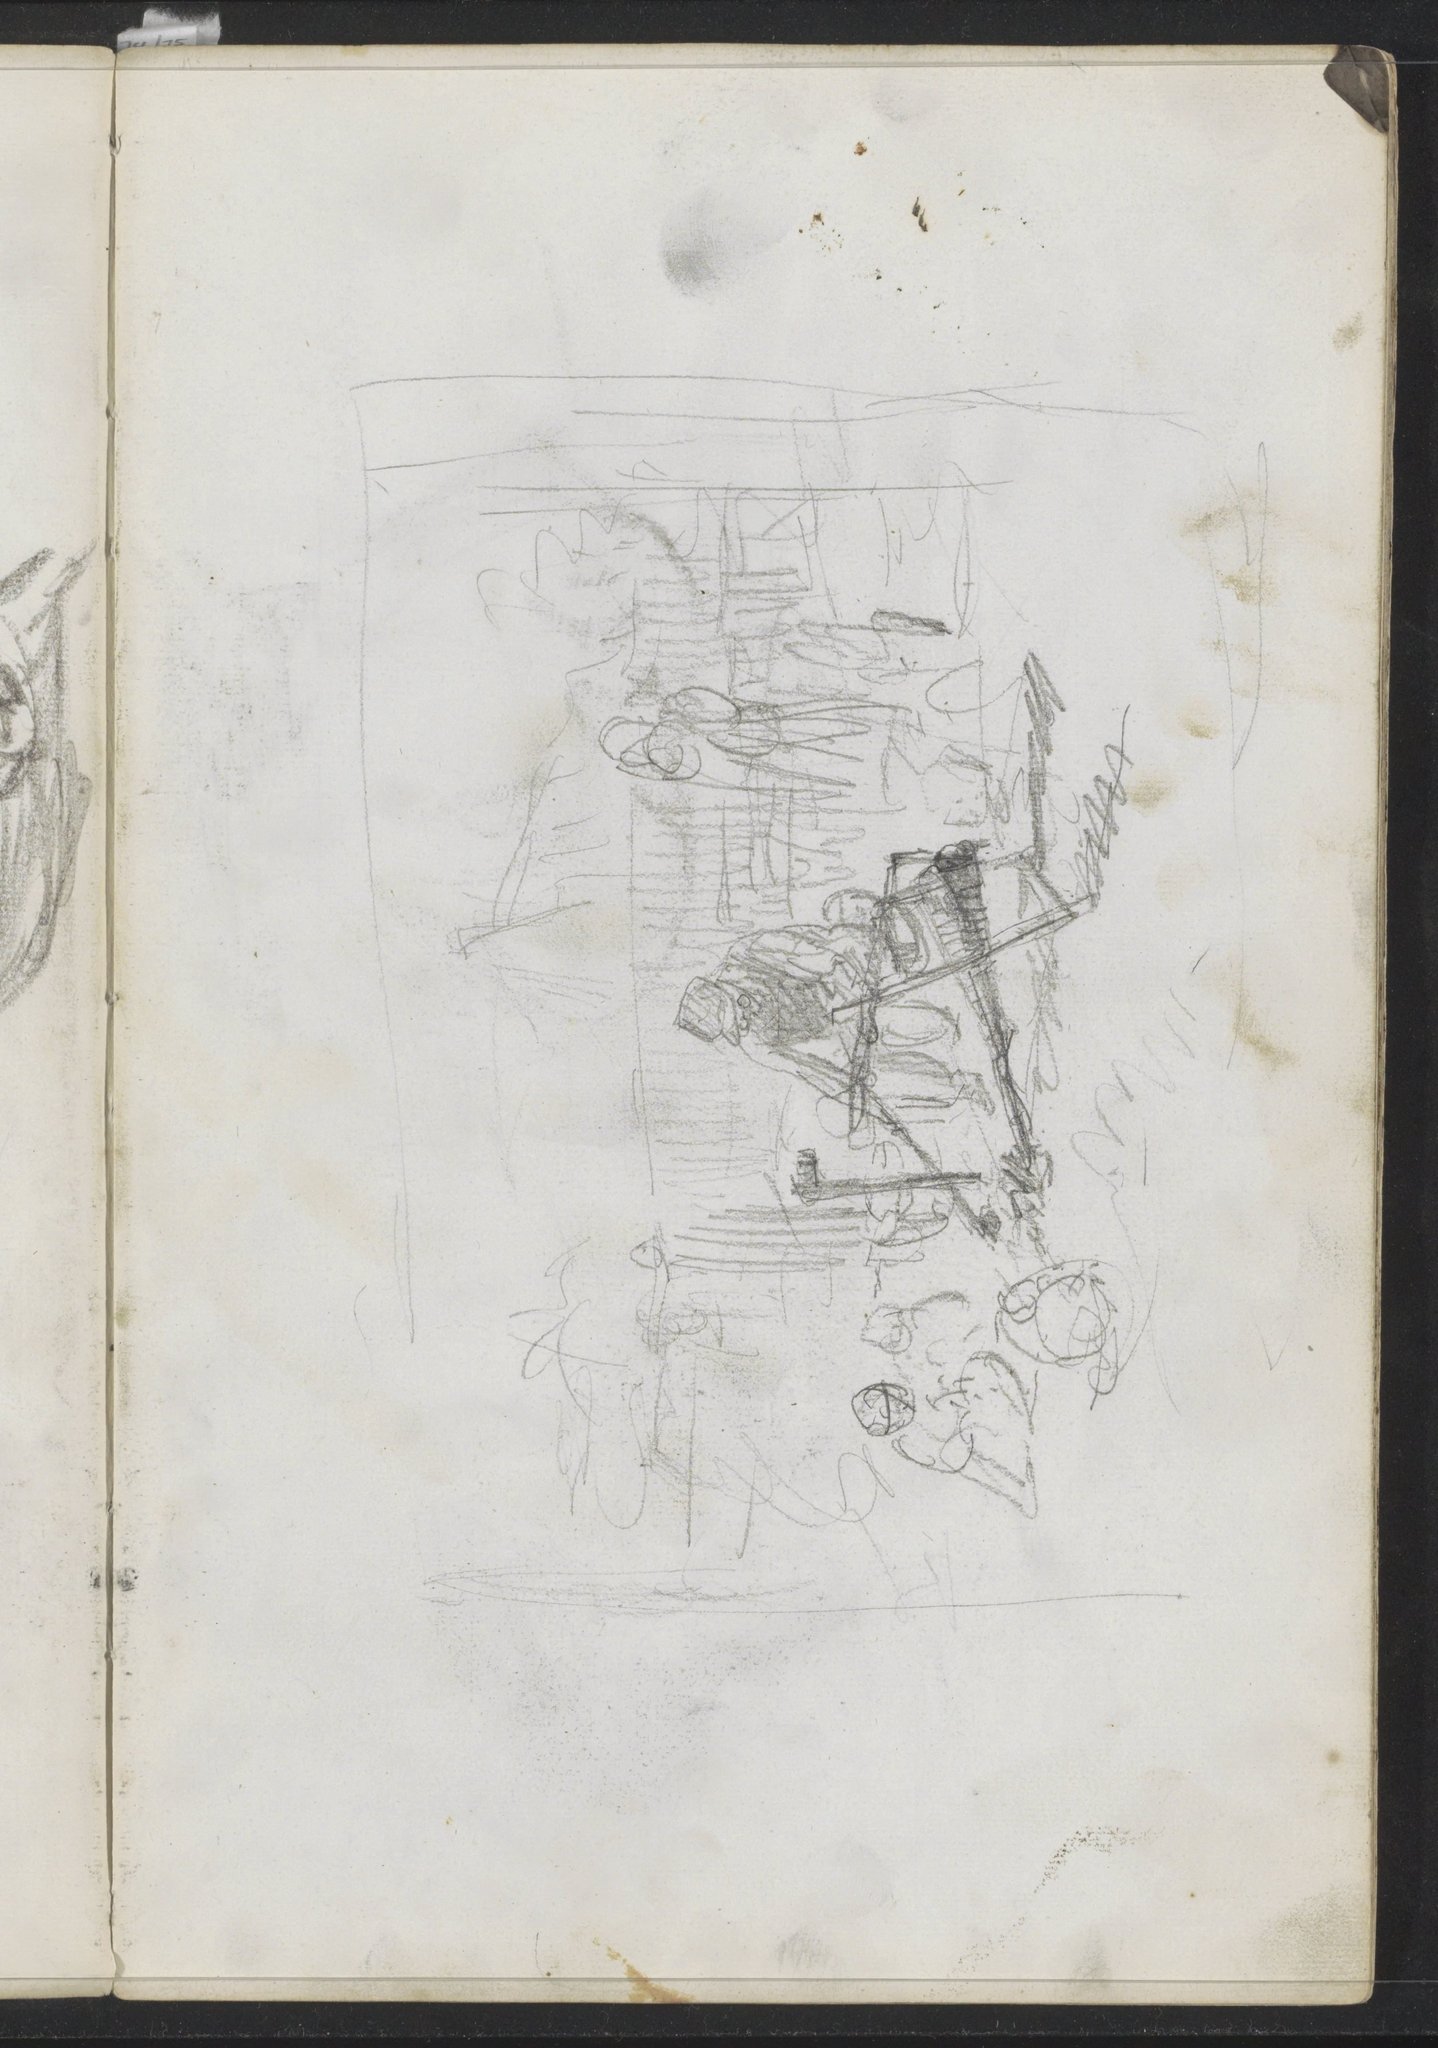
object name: sketchbook leaf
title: Man die een constructie van hout maakt in een tuin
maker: jozef israëls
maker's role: draughtsman, painter, print maker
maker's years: 1824-1911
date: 1855-1859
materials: paper, pencil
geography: zandvoort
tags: wood, timber ~ building material, garden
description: Blad 11 recto uit een schetsboek met 22 bladen.